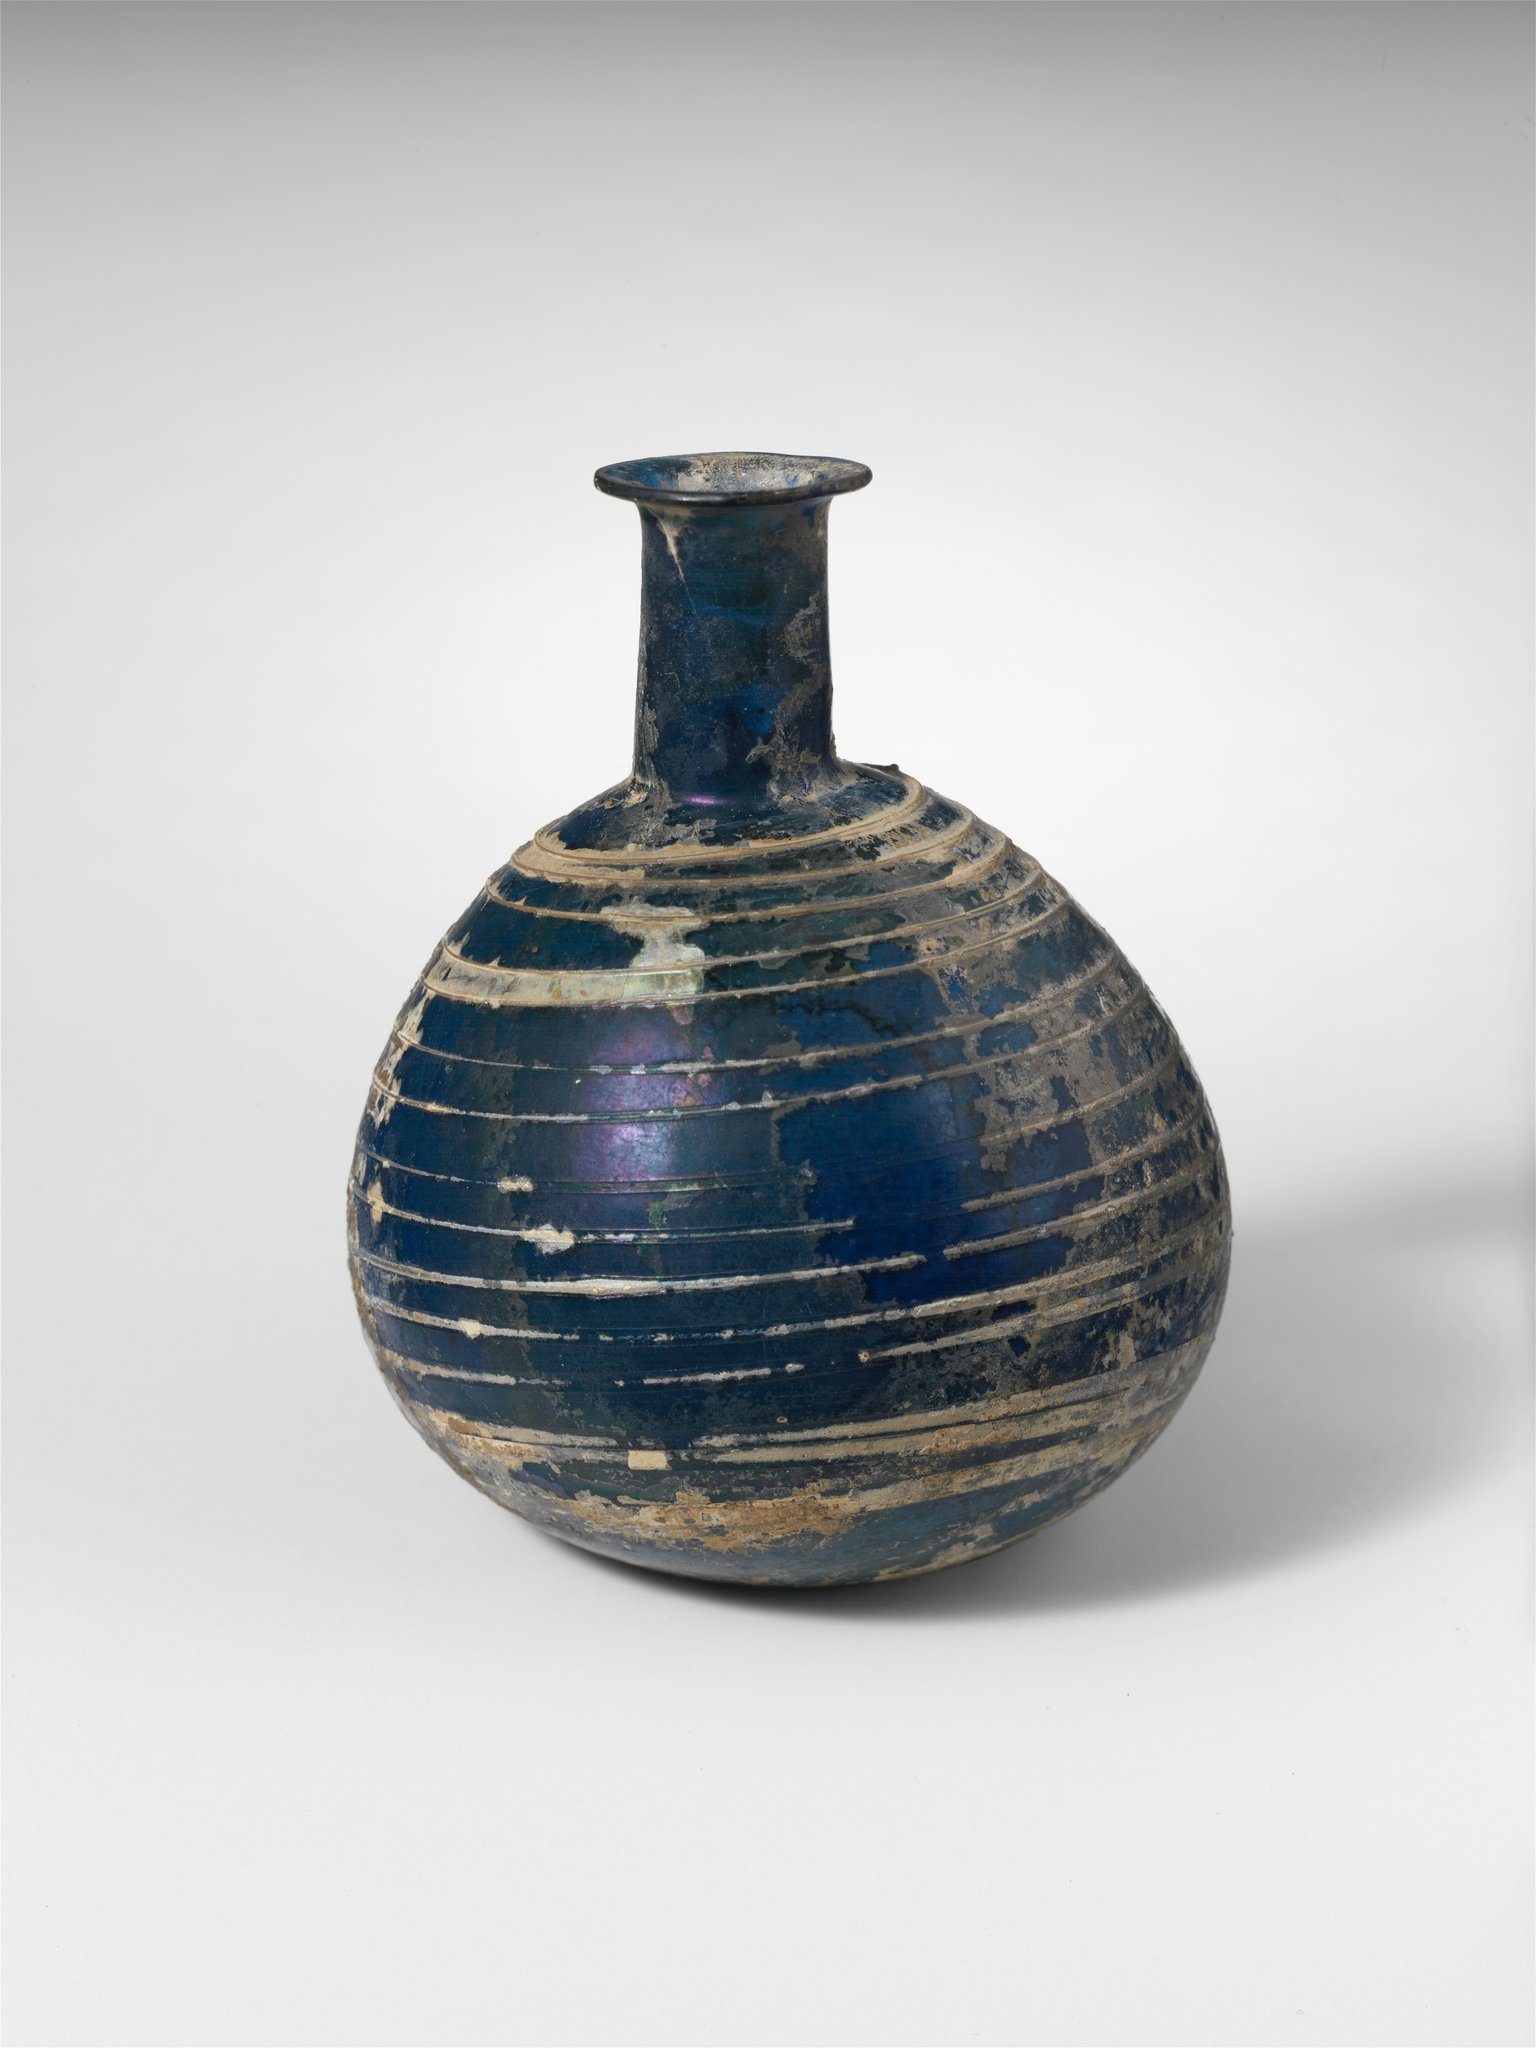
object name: perfume bottle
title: Glass perfume bottle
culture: roman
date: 1-33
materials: glass